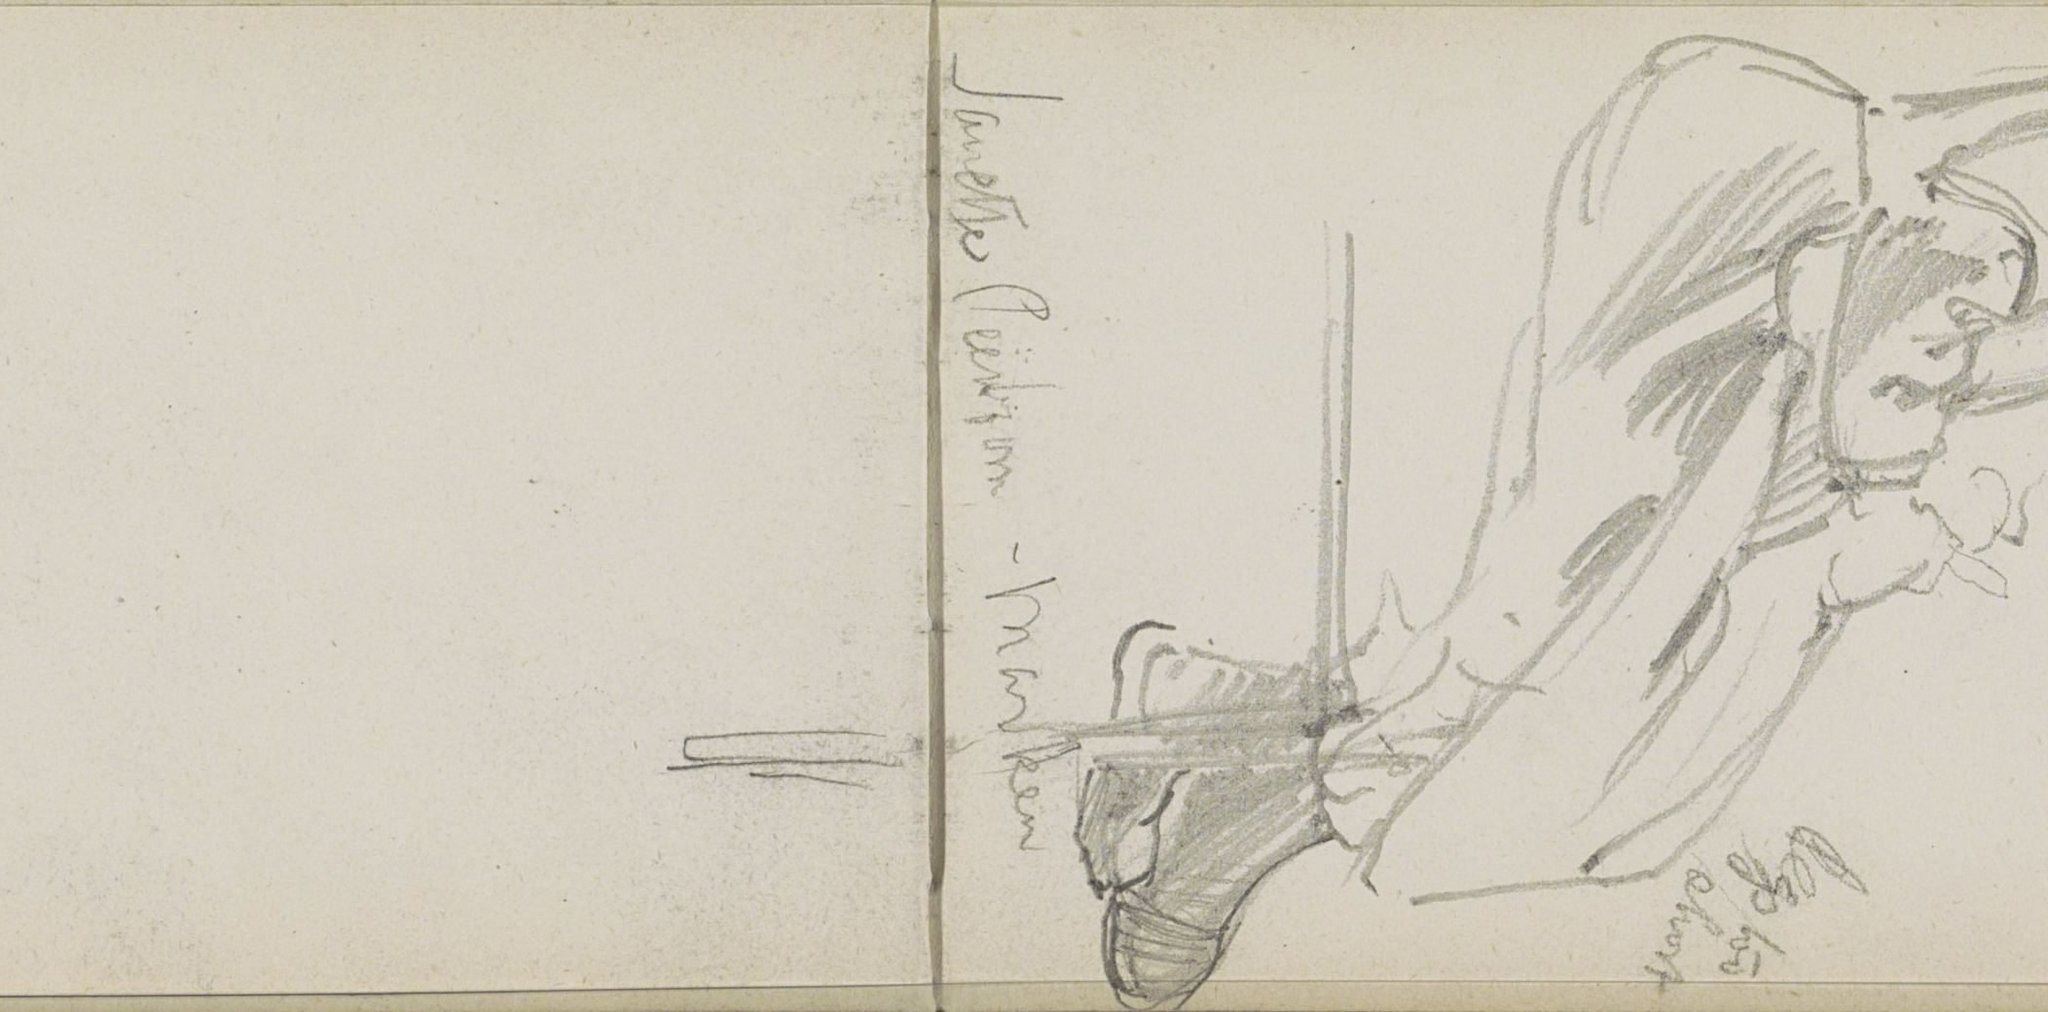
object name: sketchbook leaf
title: Janette Peereboom uit Marken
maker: george clausen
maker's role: draughtsman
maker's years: 1852-1912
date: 1875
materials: paper, pencil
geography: marken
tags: sitting figure, girl (child between toddler and youth), folk costume, regional costume, home sewing; repair of clothes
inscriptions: annotation: ‘legs too/ short/ Janette Peerboom - Marken’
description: Het meisje zit in Marker klederdracht te handwerken. Blad 24 verso en 25 recto uit een schetsboek met 46 bladen.